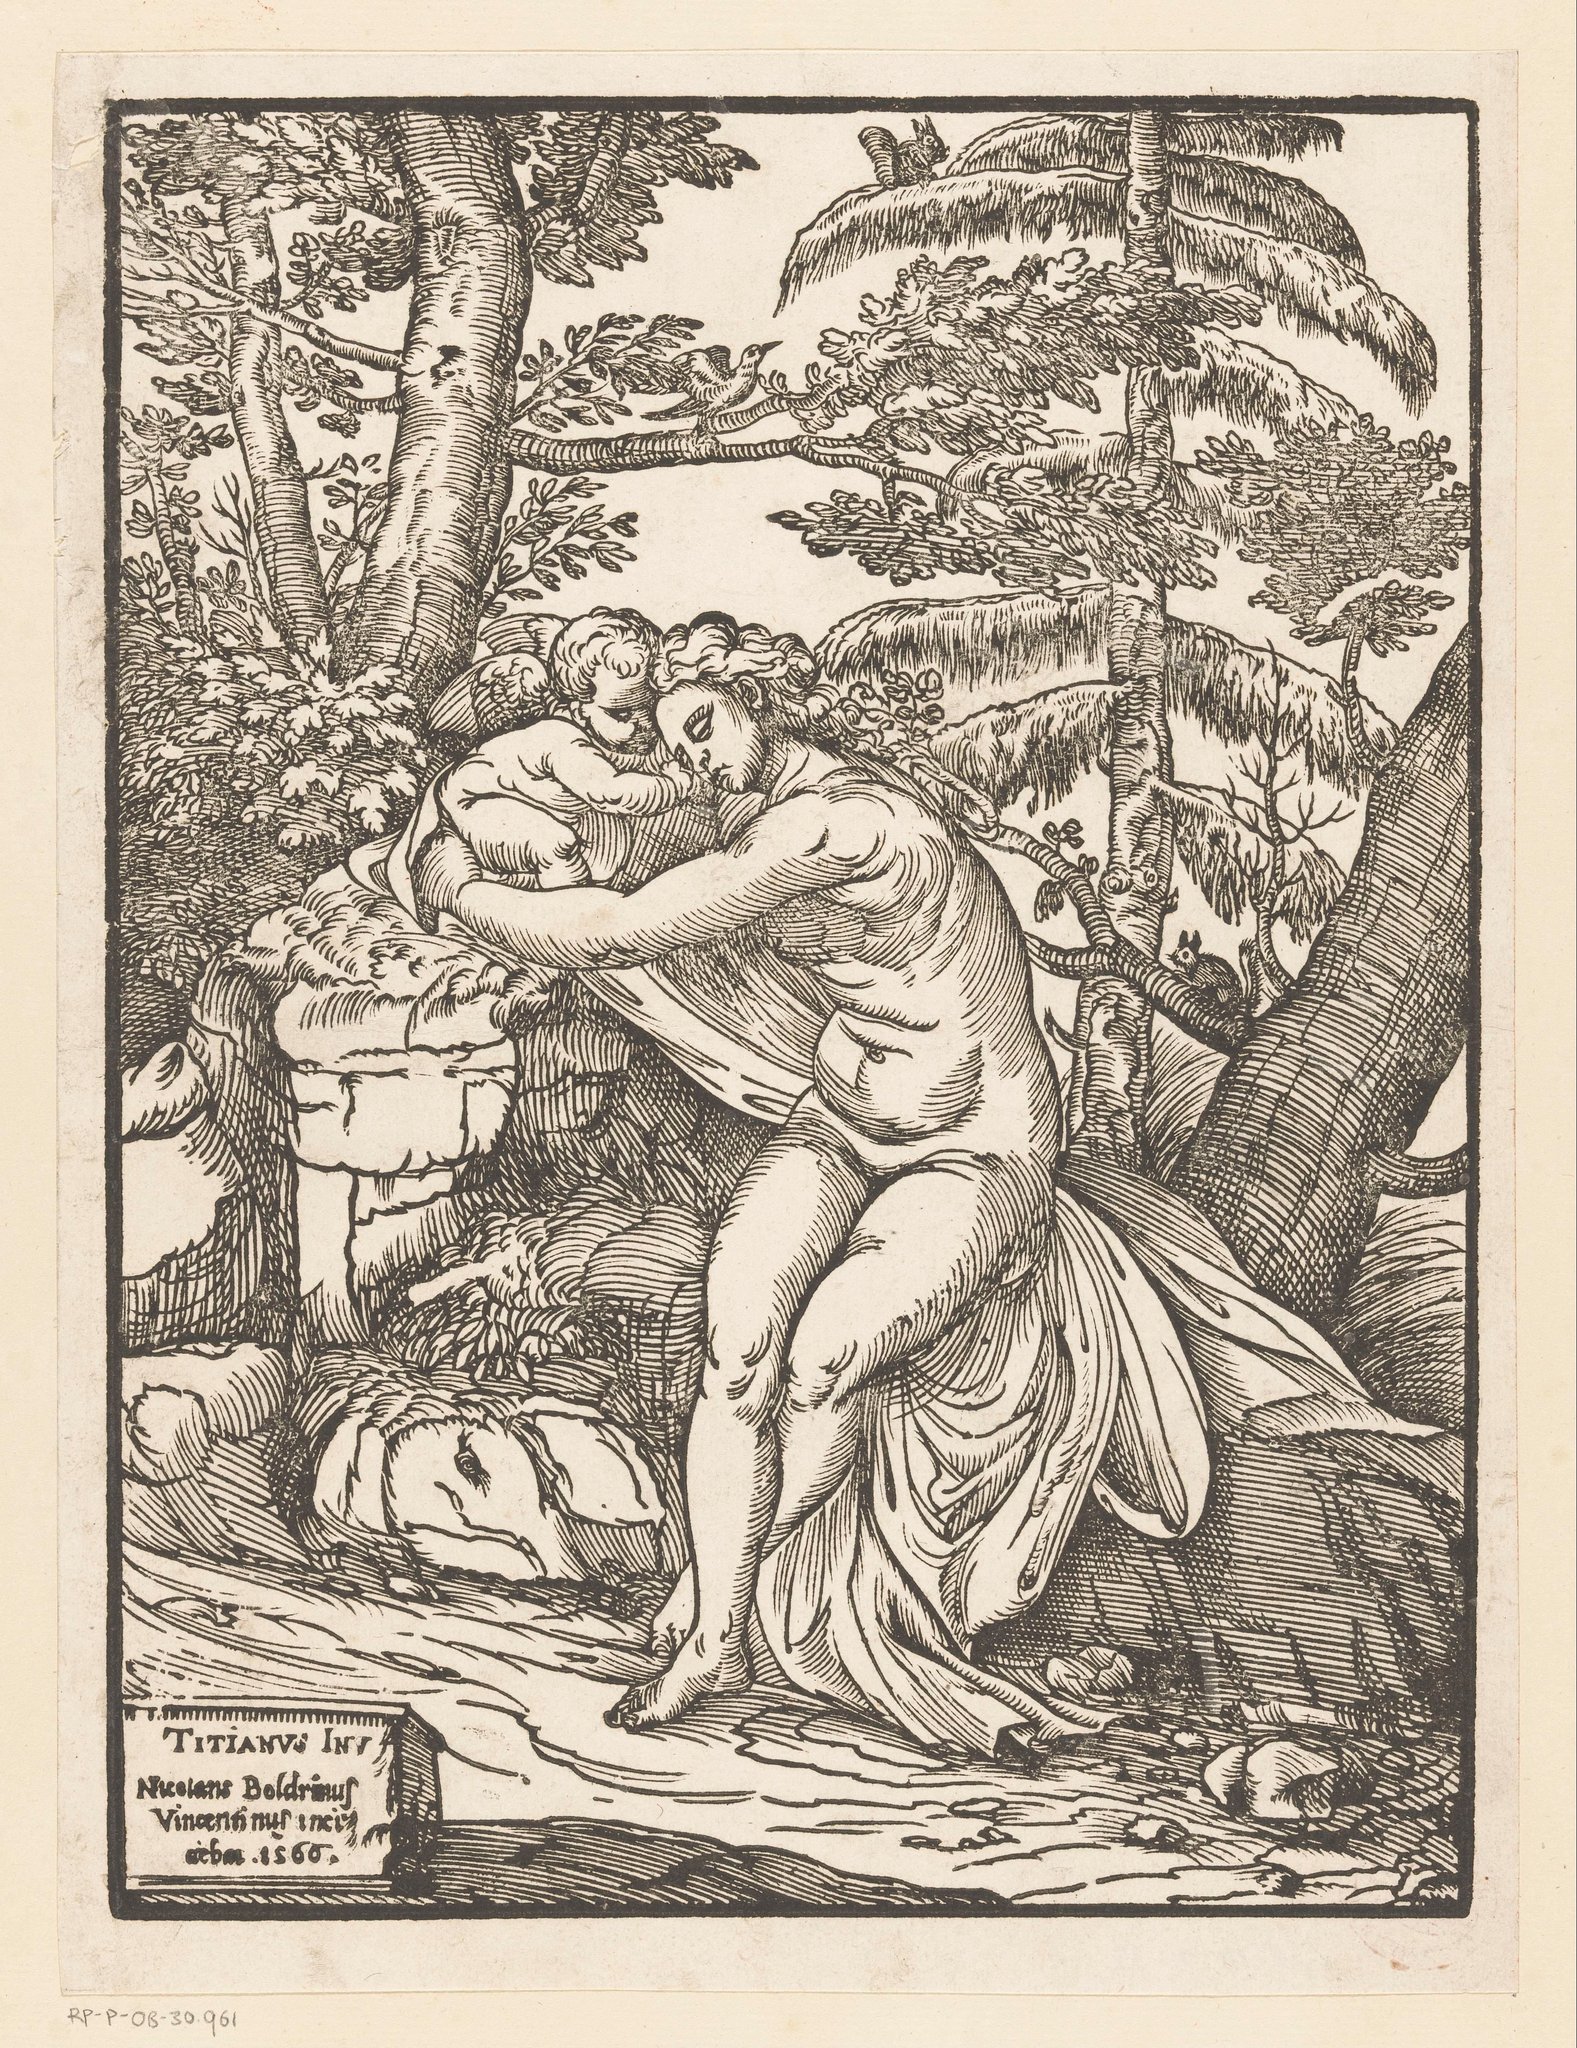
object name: print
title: Venus en Amor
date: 1566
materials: paper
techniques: woodcut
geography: italy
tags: landscapes, venus and cupid (cupid not being mere attribute)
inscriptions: collector's mark: Lugt 240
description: Amor en de naakte Venus in omhelzing in een landschap.